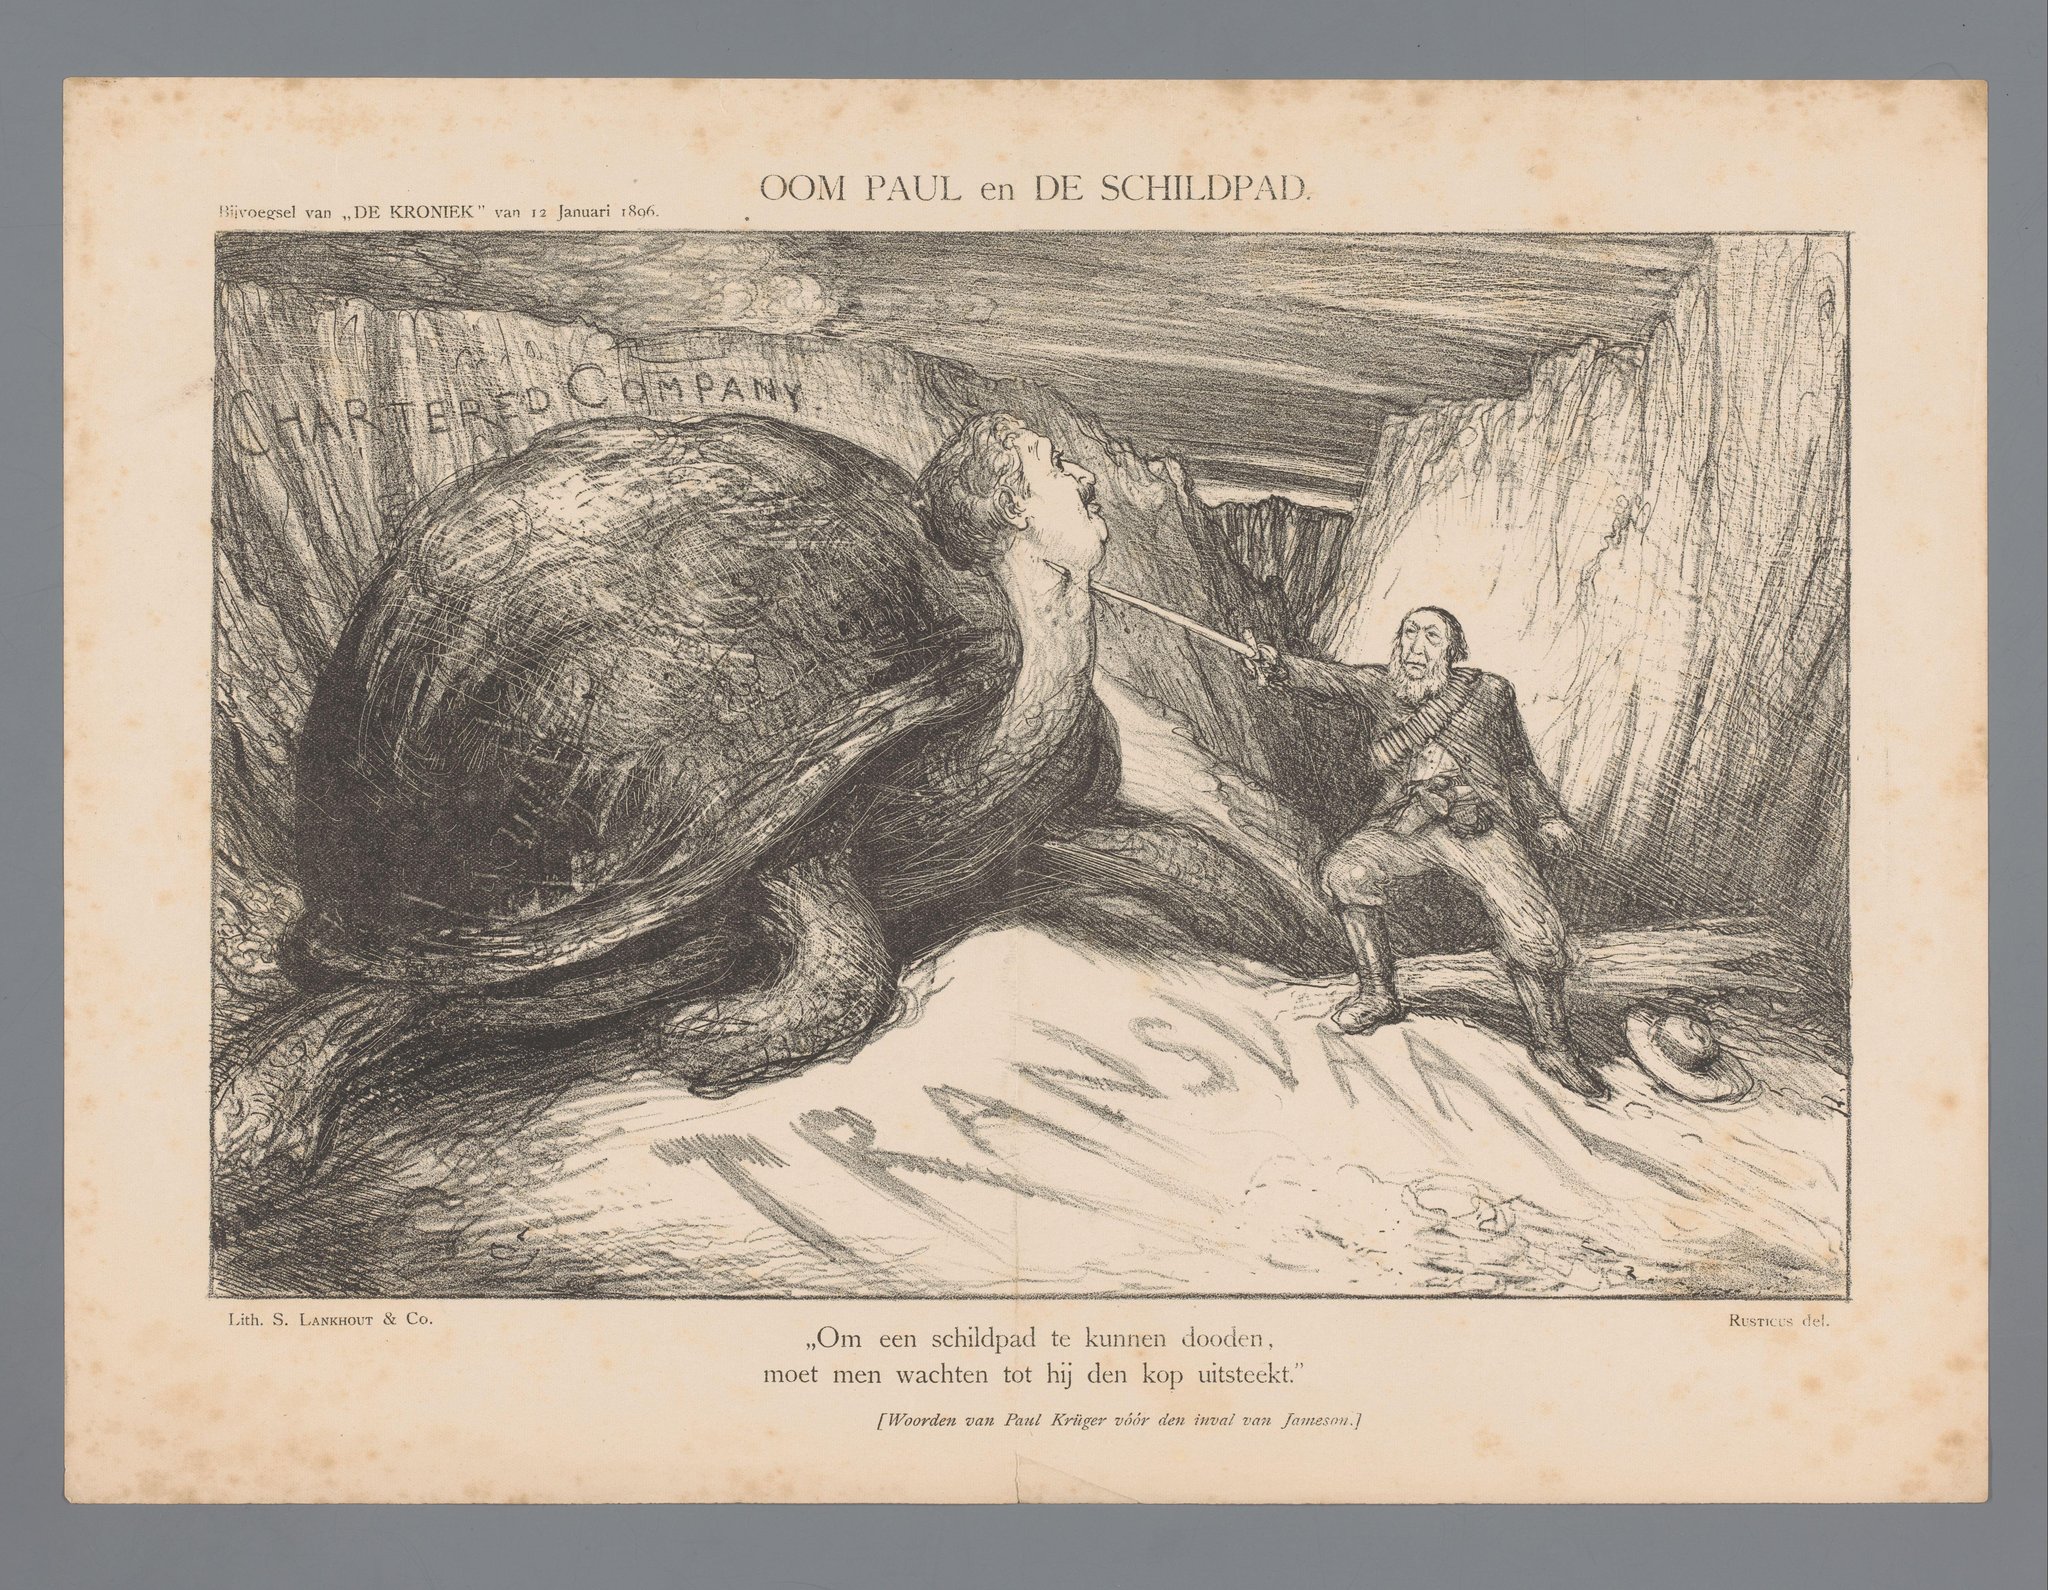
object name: cartoon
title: Oom Paul en De Schildpad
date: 1896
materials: paper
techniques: lithograph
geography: netherlands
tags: tortoises, turtles, historical persons, political caricatures and satires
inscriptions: date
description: Spotprent op de Jameson Raid in Transvaal in het weekend van 29 december 1895 op 2 januari 1896. De Zuid-Afrikaanse president Paul Kruger steekt een zwaard door de hals van een enorme schildpad met het hoofd van Dr. Leander Jameson, de leider van de inval. Onderaan een tweeregelig citaat van Kruger. Verschenen in de bijvoegsel van 'De Kroniek' van 12 januari 1896.